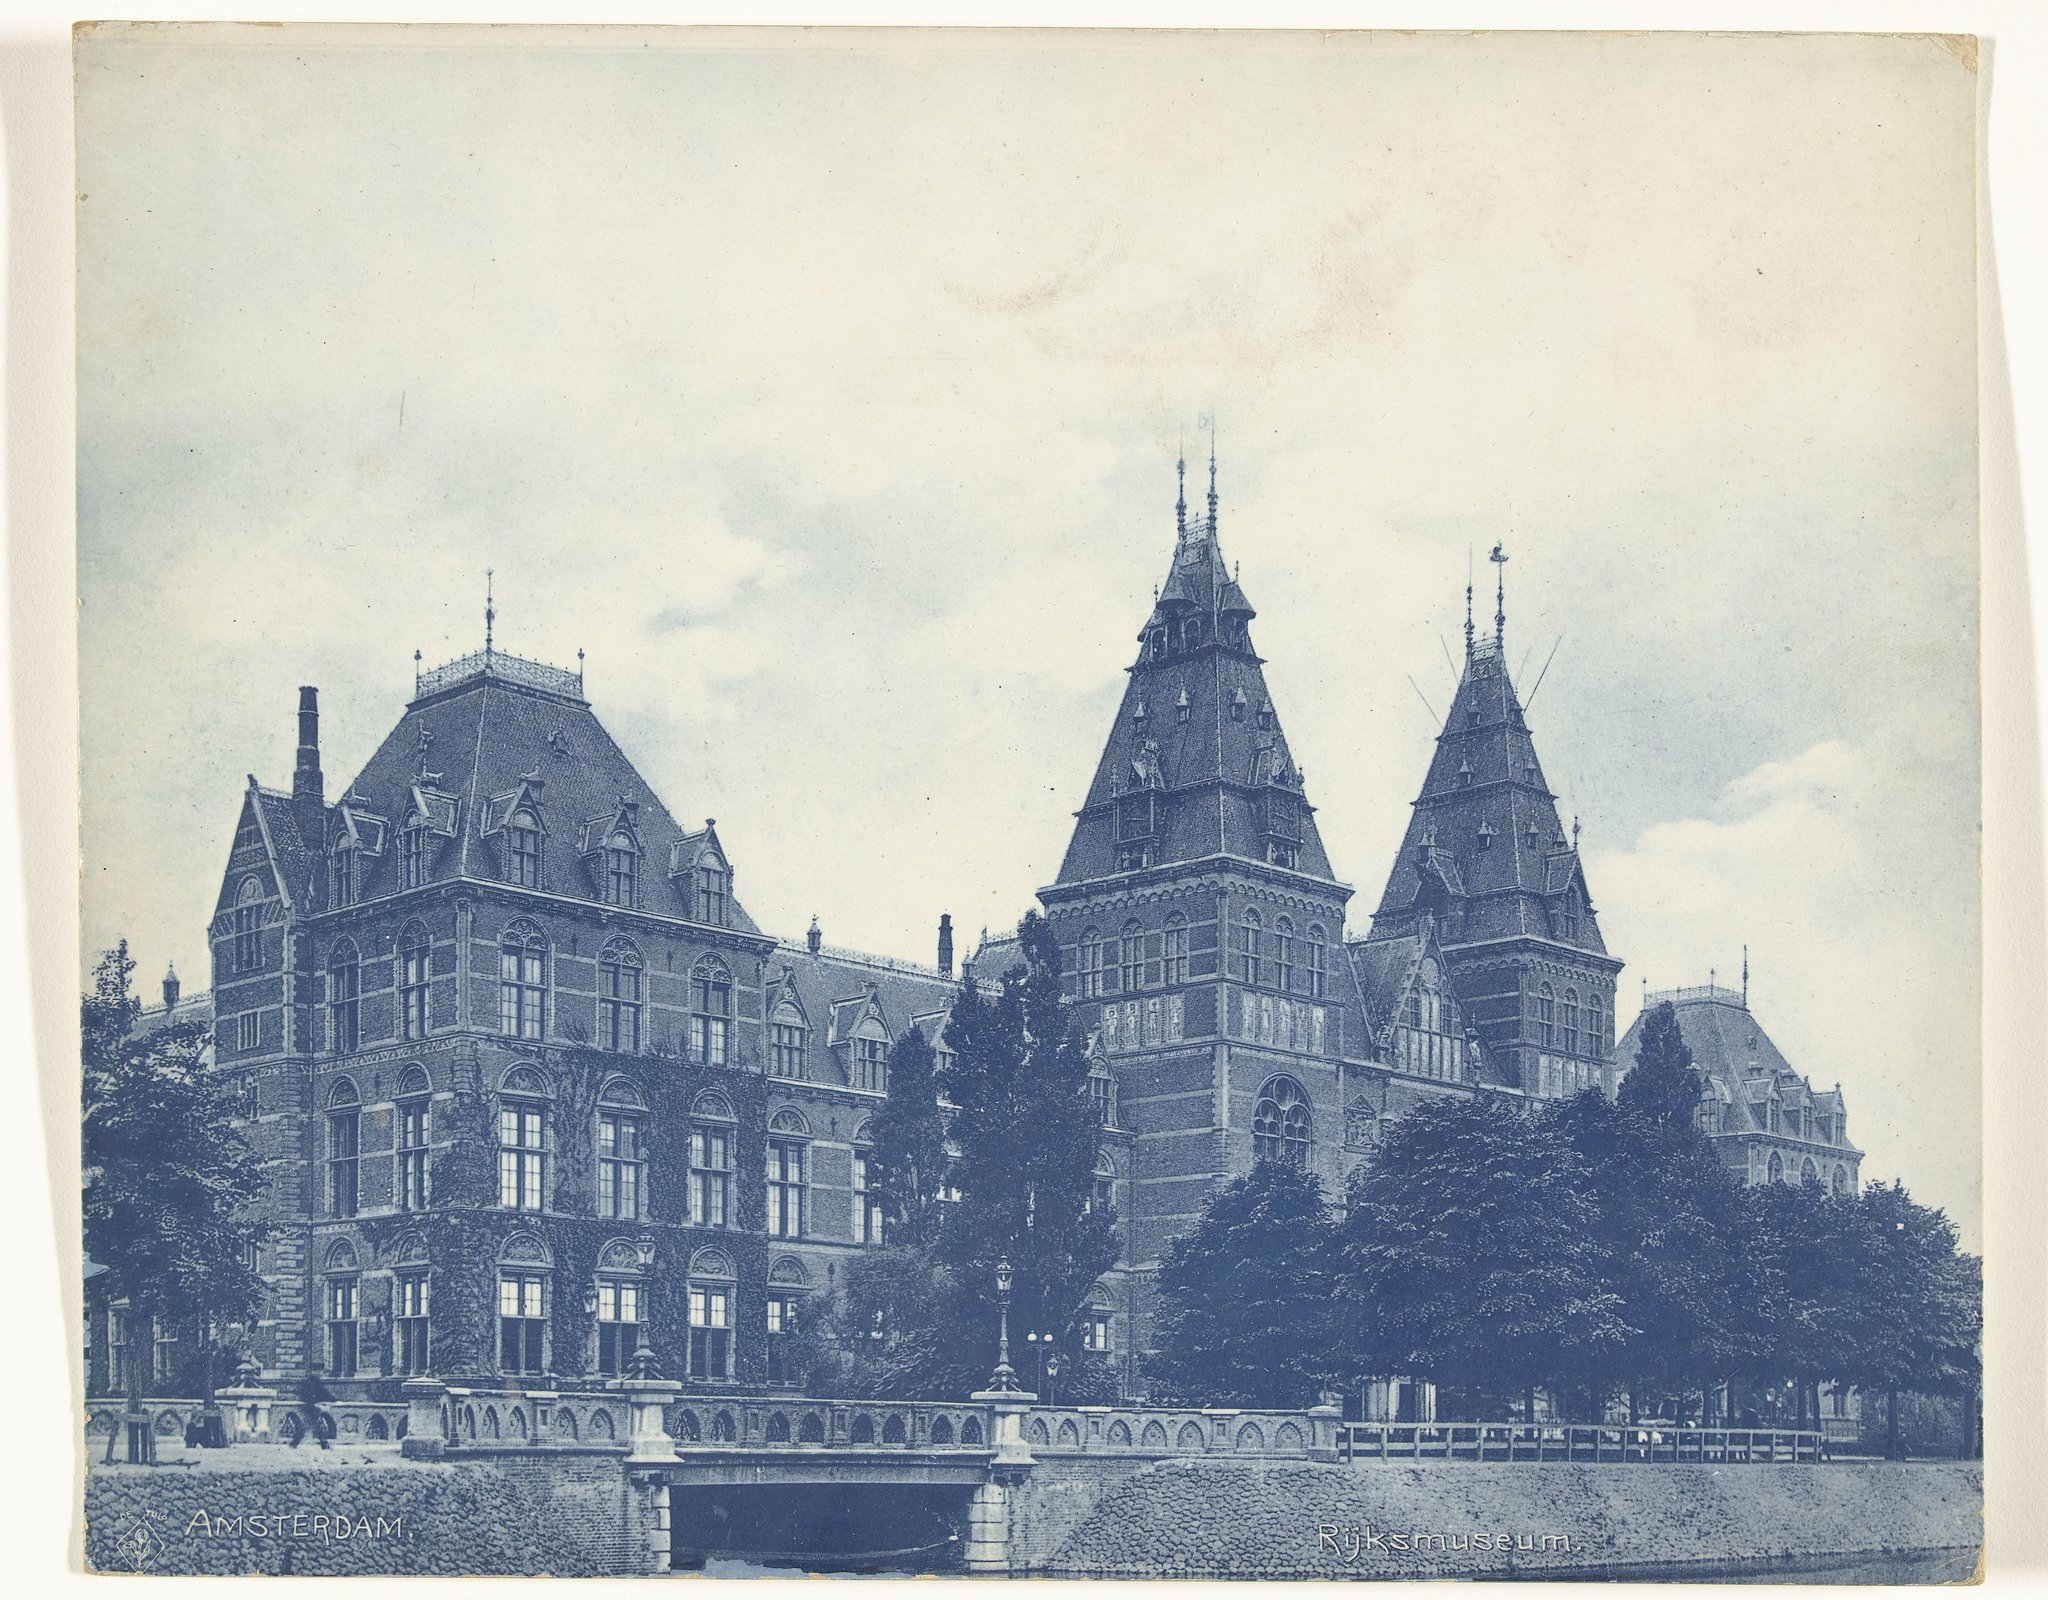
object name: fotomechanisch procedé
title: Amsterdam, Rijksmuseum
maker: Anonymous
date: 1900-1930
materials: photographic support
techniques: photograph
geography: netherlands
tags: permanent exhibition, museum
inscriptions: inscription: ‘DE TULP / AMSTERDAM / Rijksmuseum’